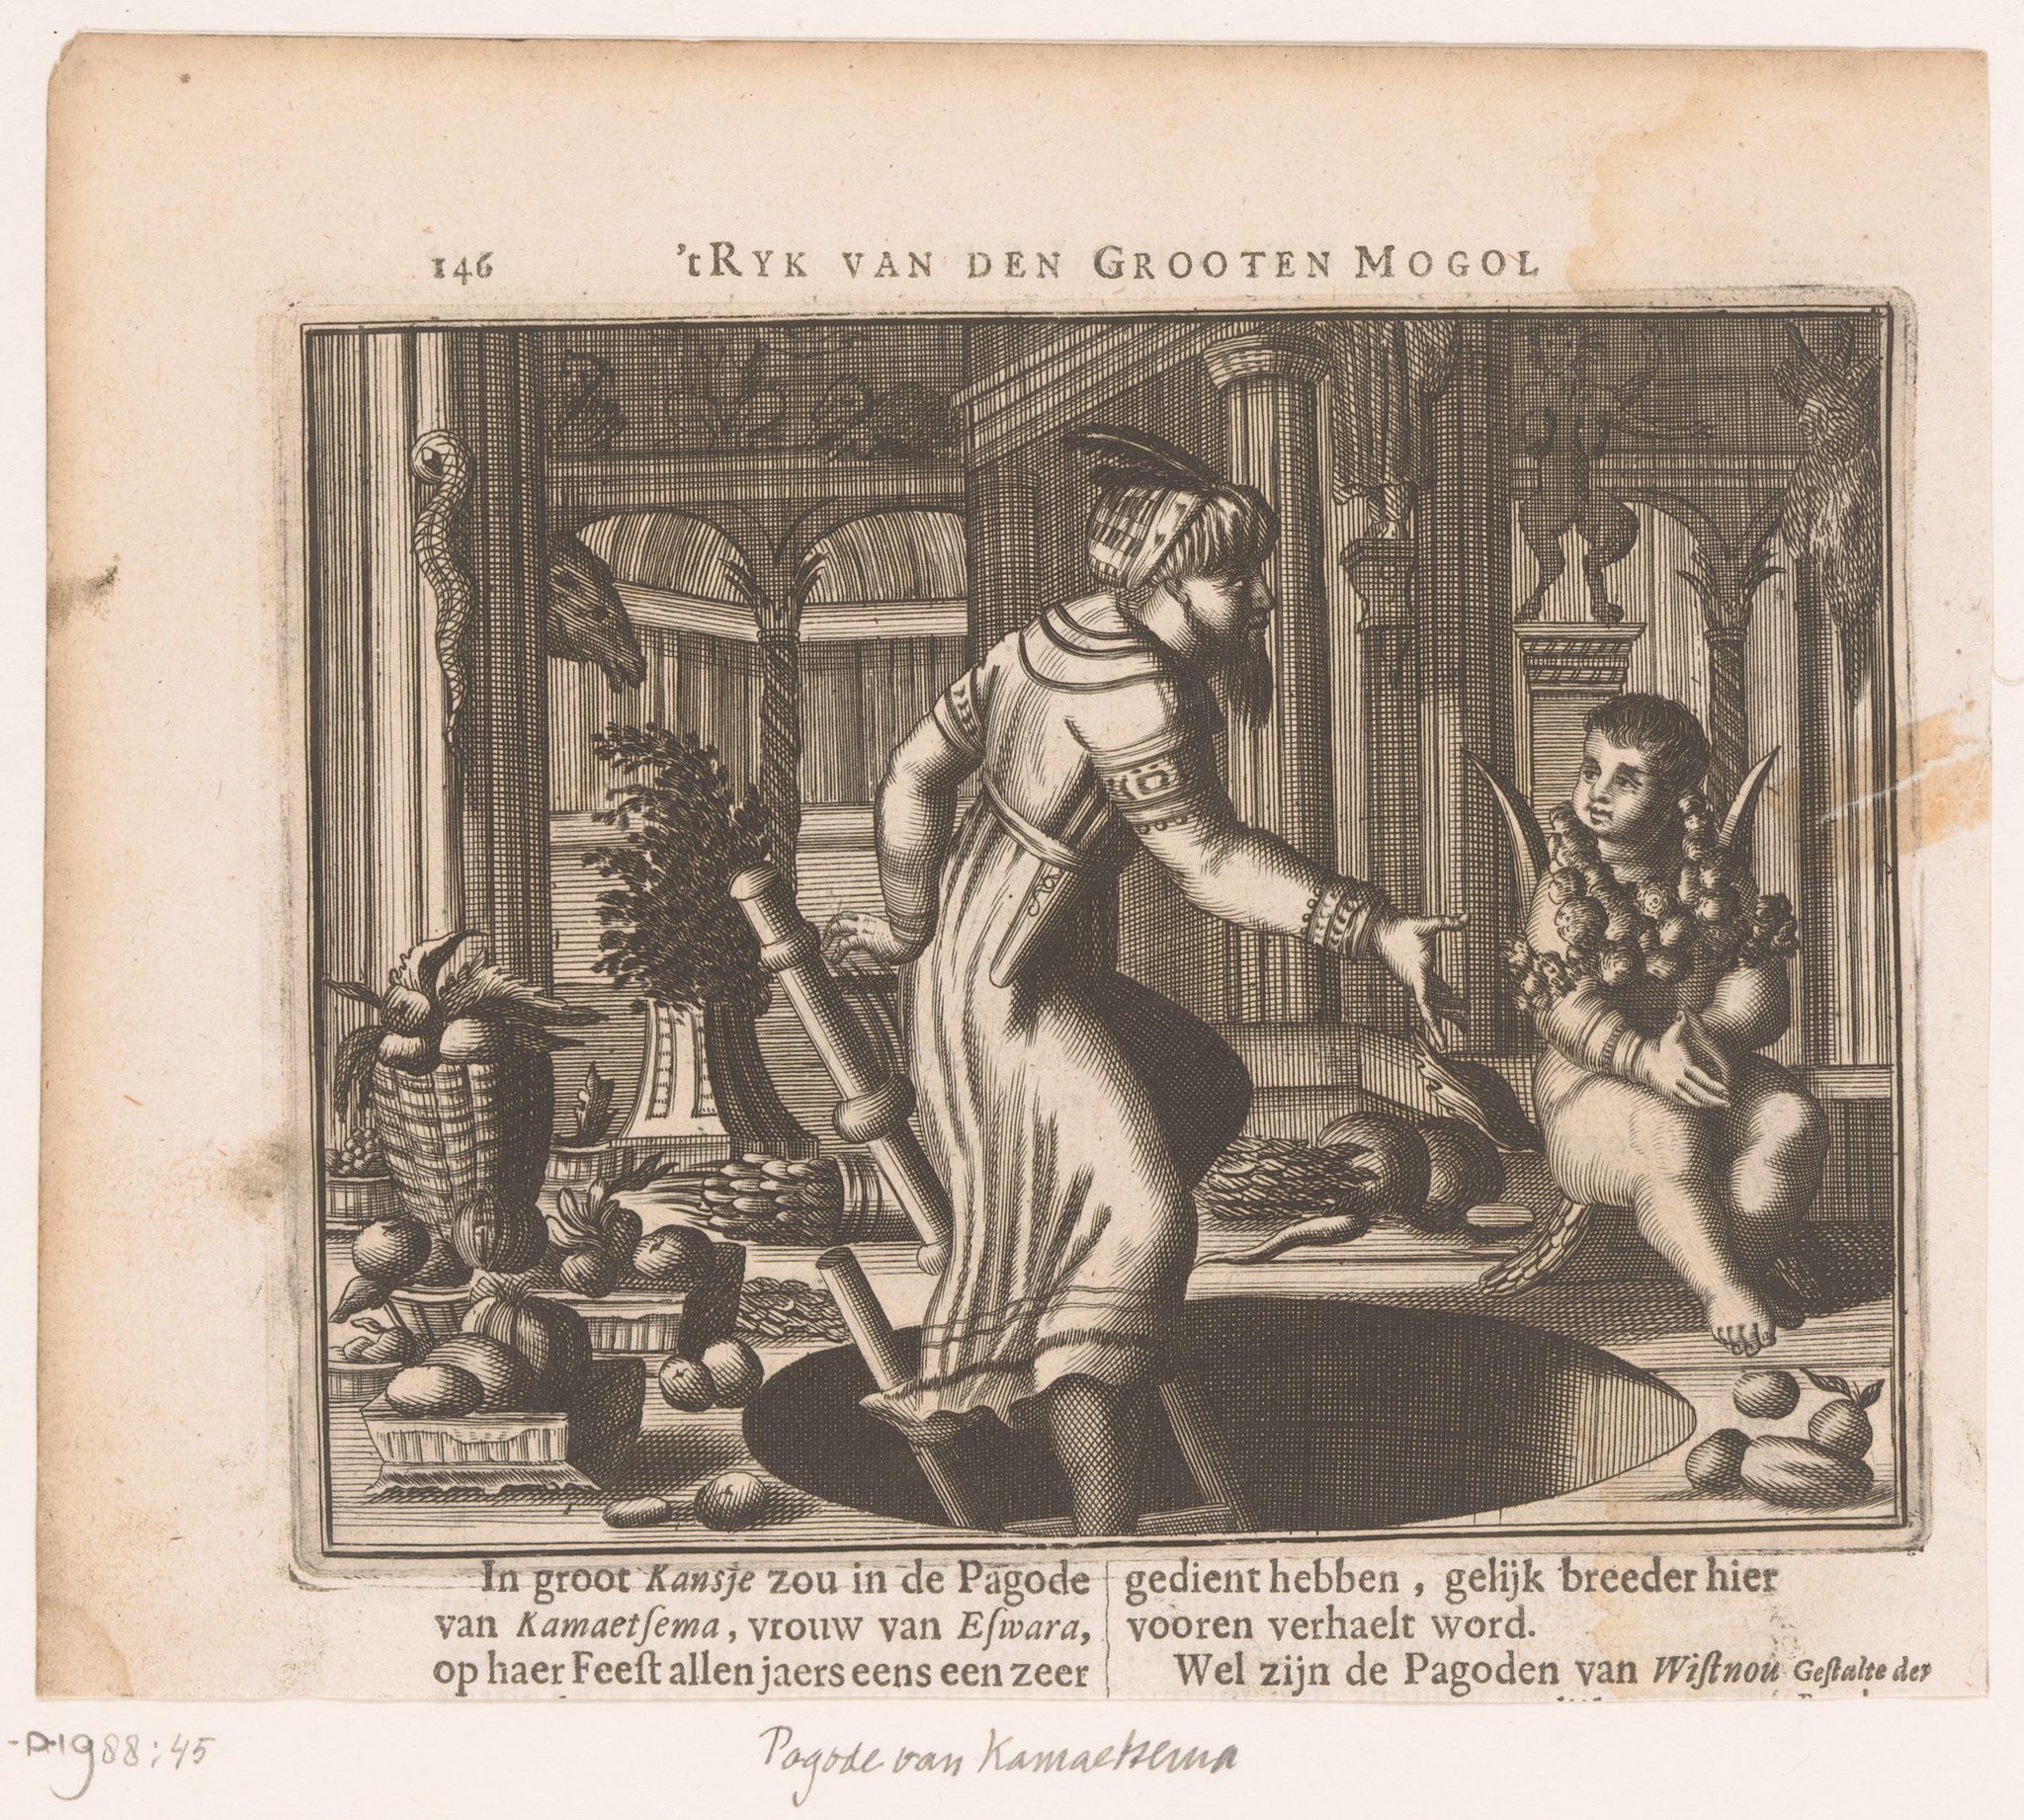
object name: print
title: Man klimt een ladder omhoog uit een diepe put om een pagode binnen te komen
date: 1672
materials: paper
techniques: engraving, etching, letterpress printing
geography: amsterdam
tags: temple, shrine ~ hinduism, buddhism, jainism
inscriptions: collector's mark: Lugt 2228, collector's mark: Lugt 2760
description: Prent uit: Dapper, Olfert. Asia, of naukeurige beschryving van het rijk des grooten Mogols (...). Amsterdam: Jakob van Meurs, 1672, p. 146.